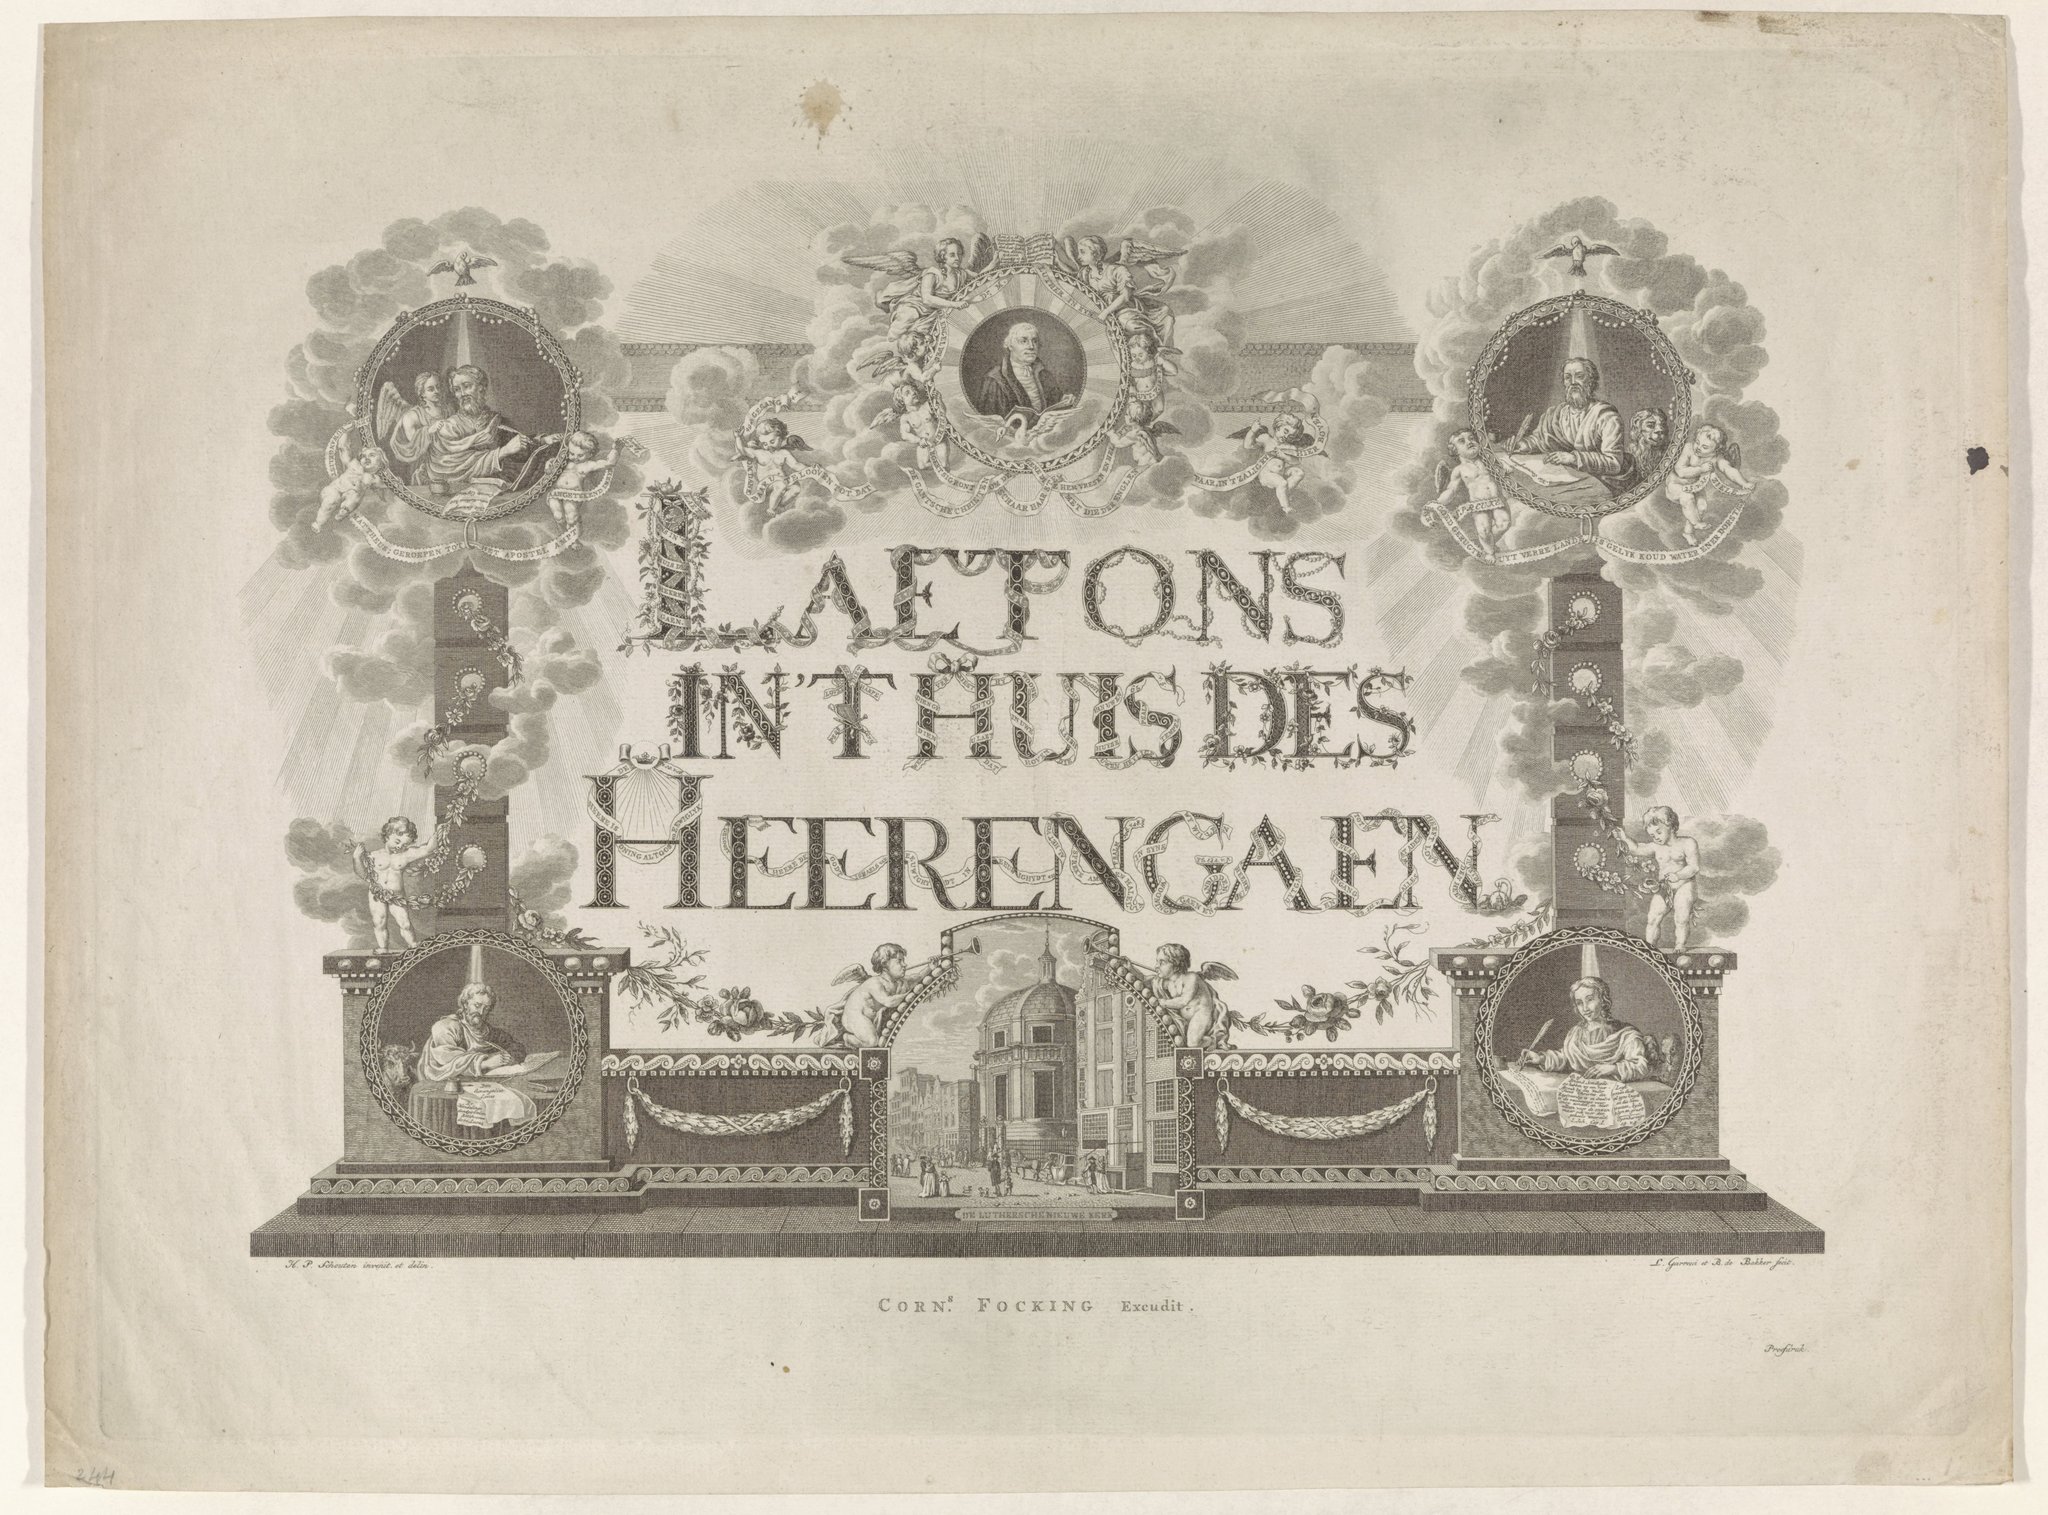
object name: print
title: Laet ons in 't huis des Heren gaen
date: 1791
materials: paper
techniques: etching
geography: amsterdam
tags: priest, martin luther, evangelists, usually with books or scrolls (not in biblical context)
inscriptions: collector's mark: Lugt 2228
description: Een ornamenteel kader rond de wooren 'Laet ons in 't huis des Heeren gaen', met bovenaan in het midden een portret van Martin Luther in een medaillon, omringd met putti. Op de vier hoeken vier medaillons met de vier evangelisten en hun attributen. Midden onder een afbeelding van de Nieuwe Lutherse Kerk te Amsterdam.